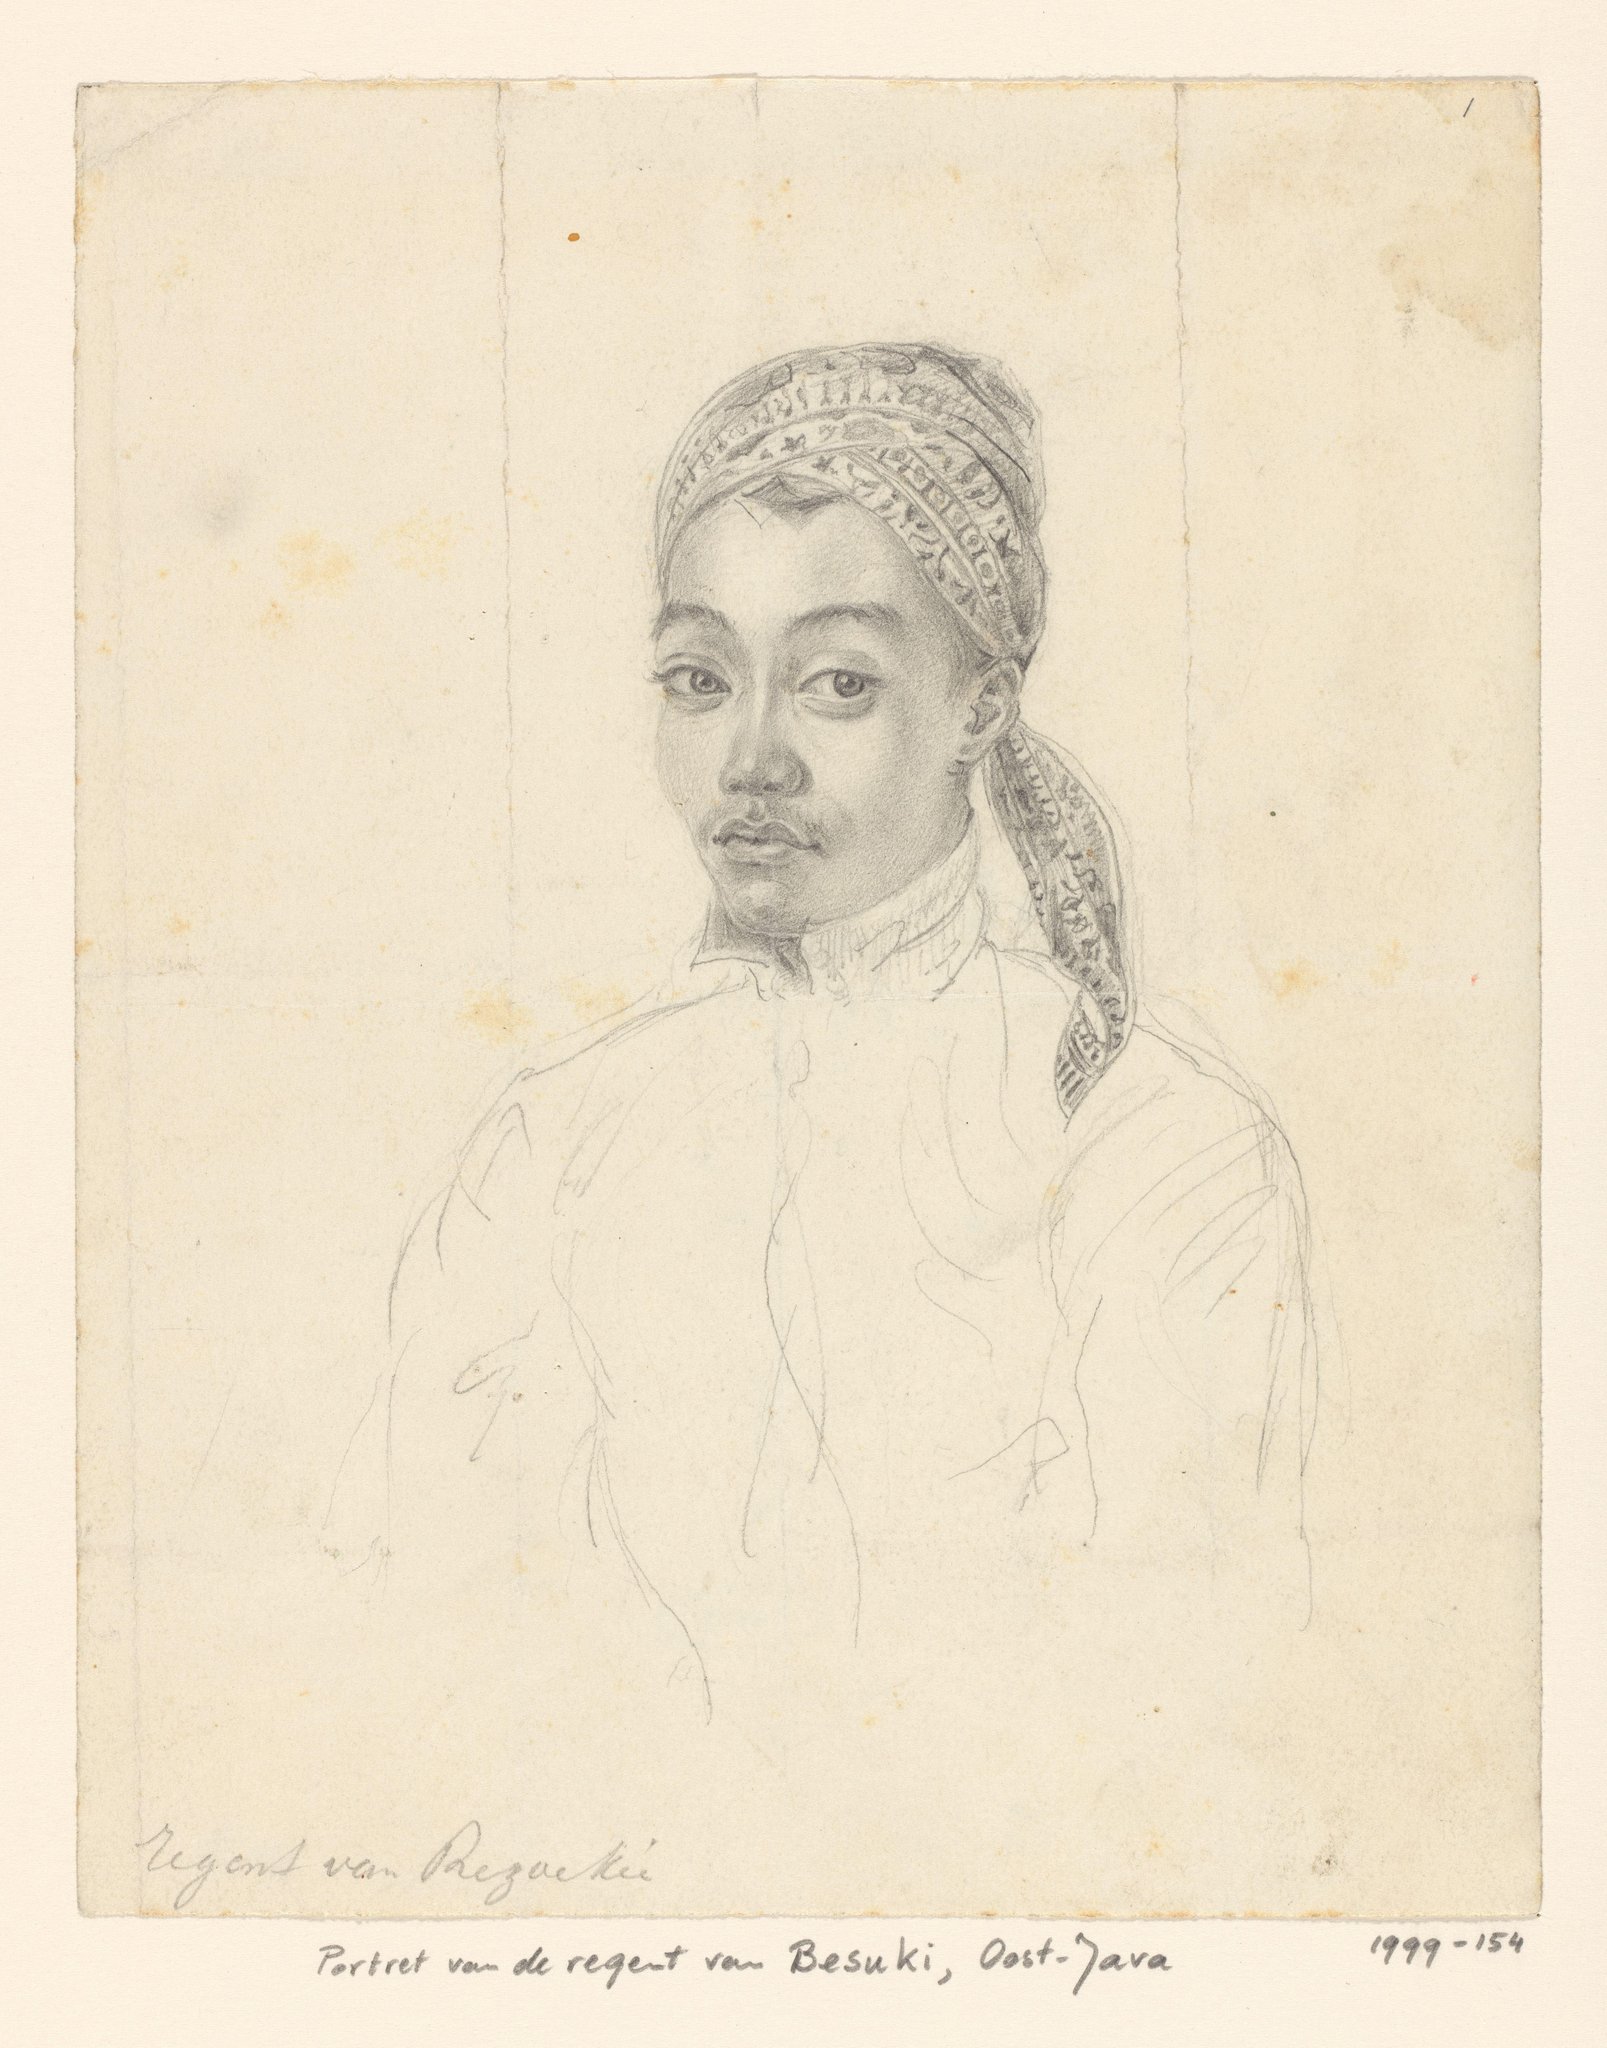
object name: drawing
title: Portret van de regent Raden Adipati Aria Prawira Adiningrat van Besuki, Oost-Java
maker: adrianus johannes bik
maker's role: draughtsman, print maker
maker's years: 1790-1872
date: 1821-1822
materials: paper, pencil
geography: east java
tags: oost-java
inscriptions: annotation: ‘regent van Bezoeki’